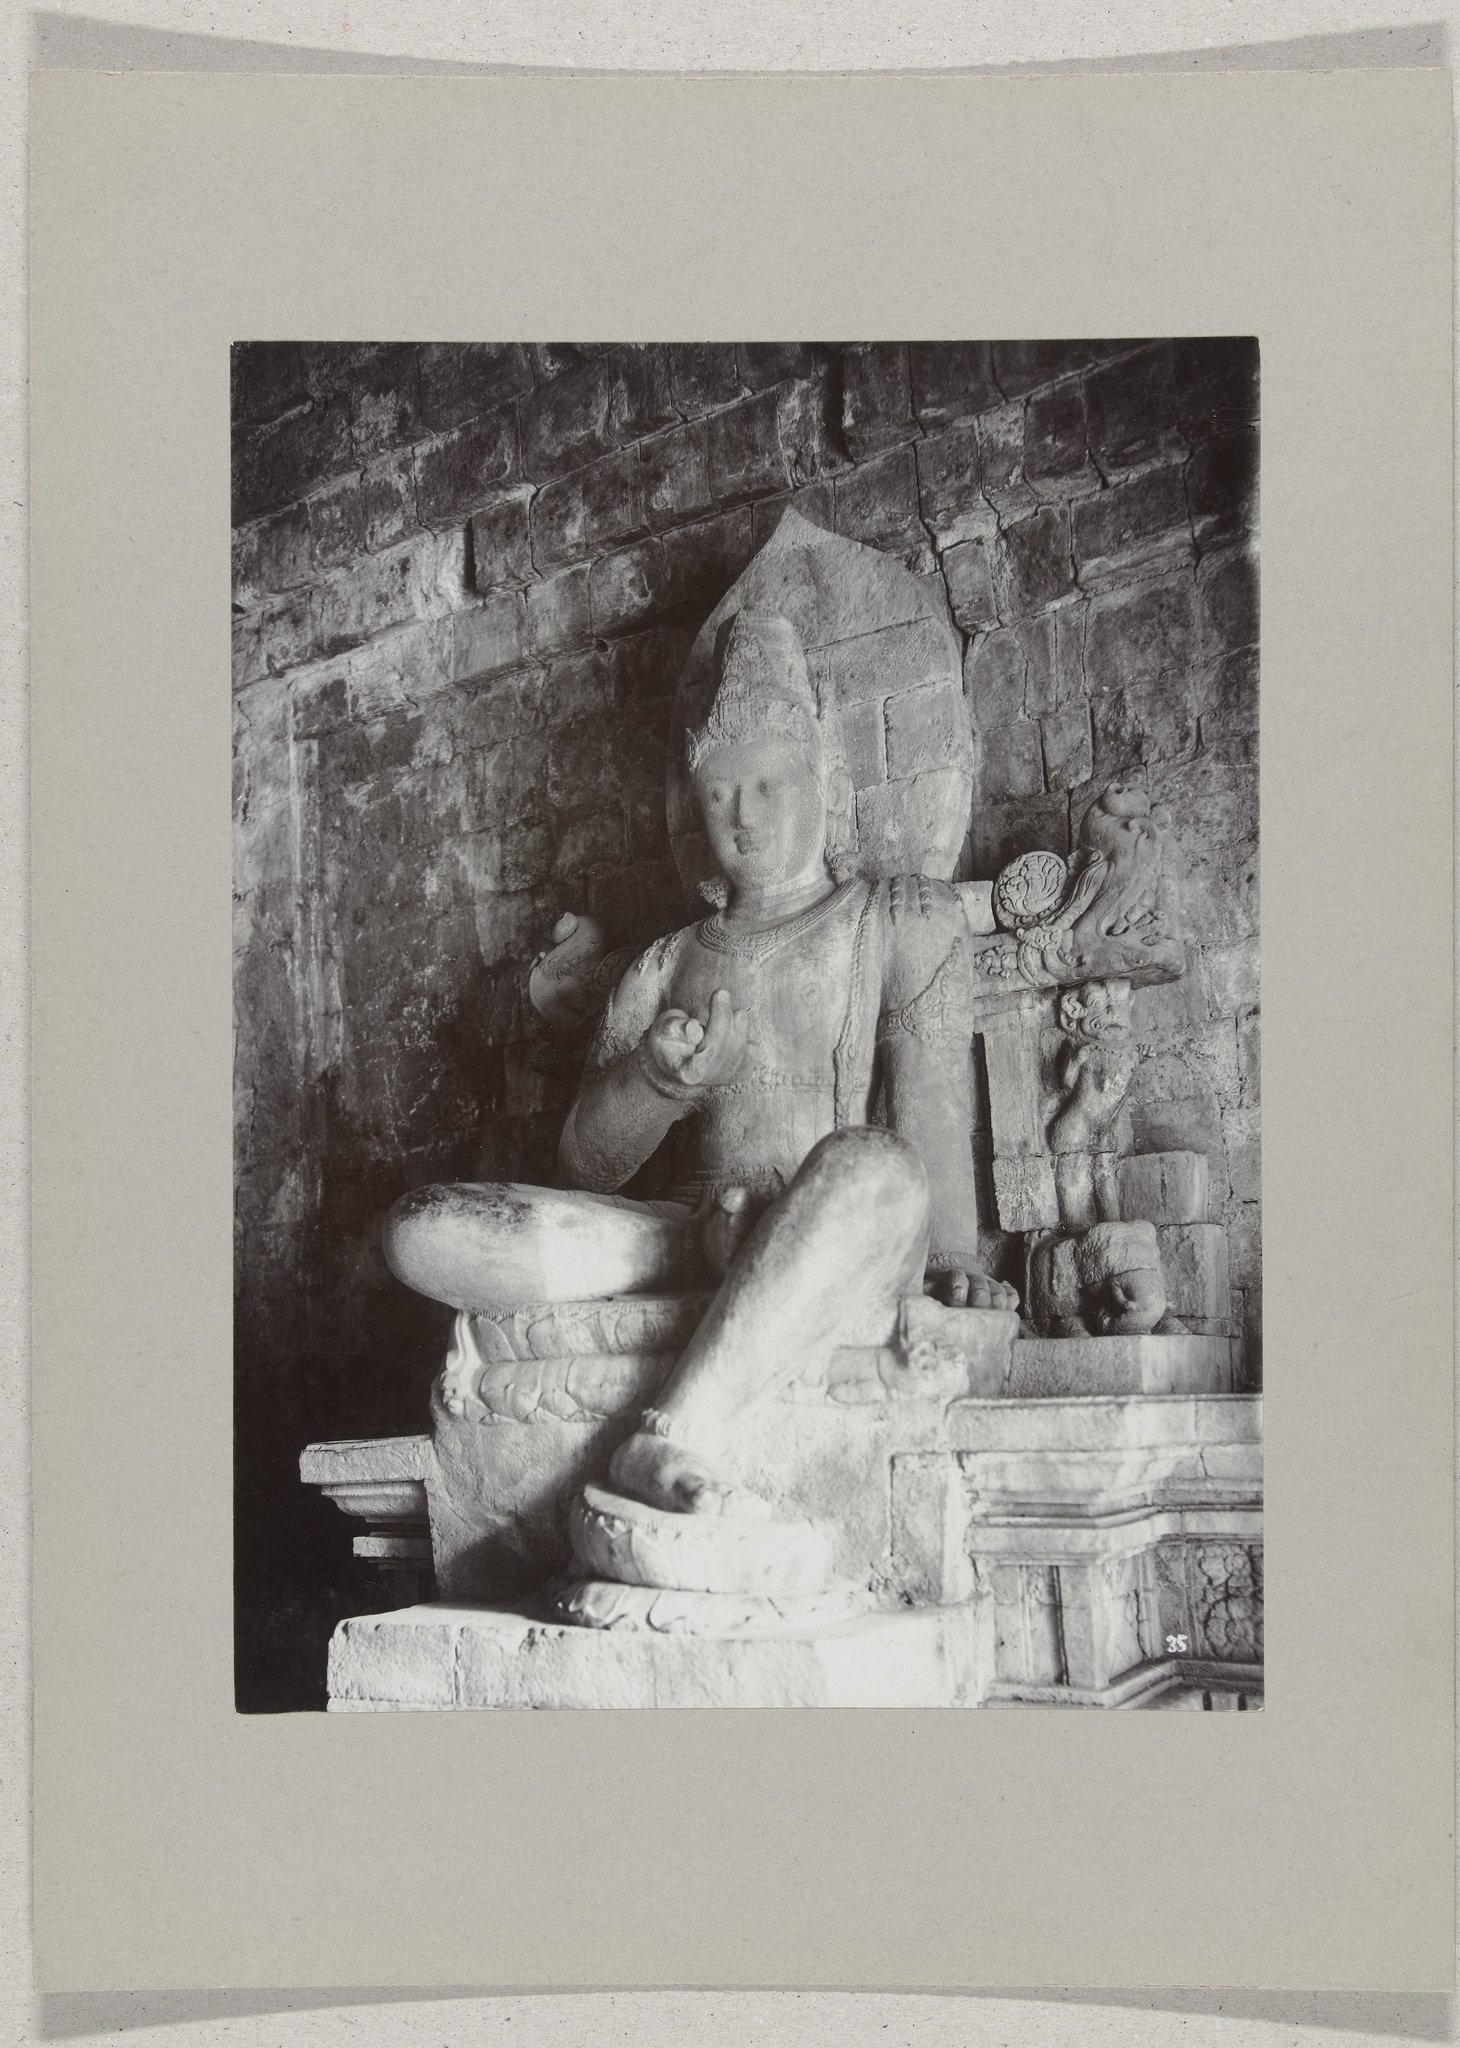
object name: photograph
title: Beeld van een van de twee koningszonen in de Tempel Mendoet ten zuiden van Magelang, Nederlands-Indië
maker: onnes kurkdjian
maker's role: fotograaf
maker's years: 1851-1903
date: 1895-1915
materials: cardboard, paper, photographic support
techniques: gelatin silver print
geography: magelang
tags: candi mendut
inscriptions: annotation: ‘76. Mendoet’, number: ‘35’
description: Beeld van een van de twee koningszonen in de Tempel Mendoet ten zuiden van Magelang, Nederlands-Indië